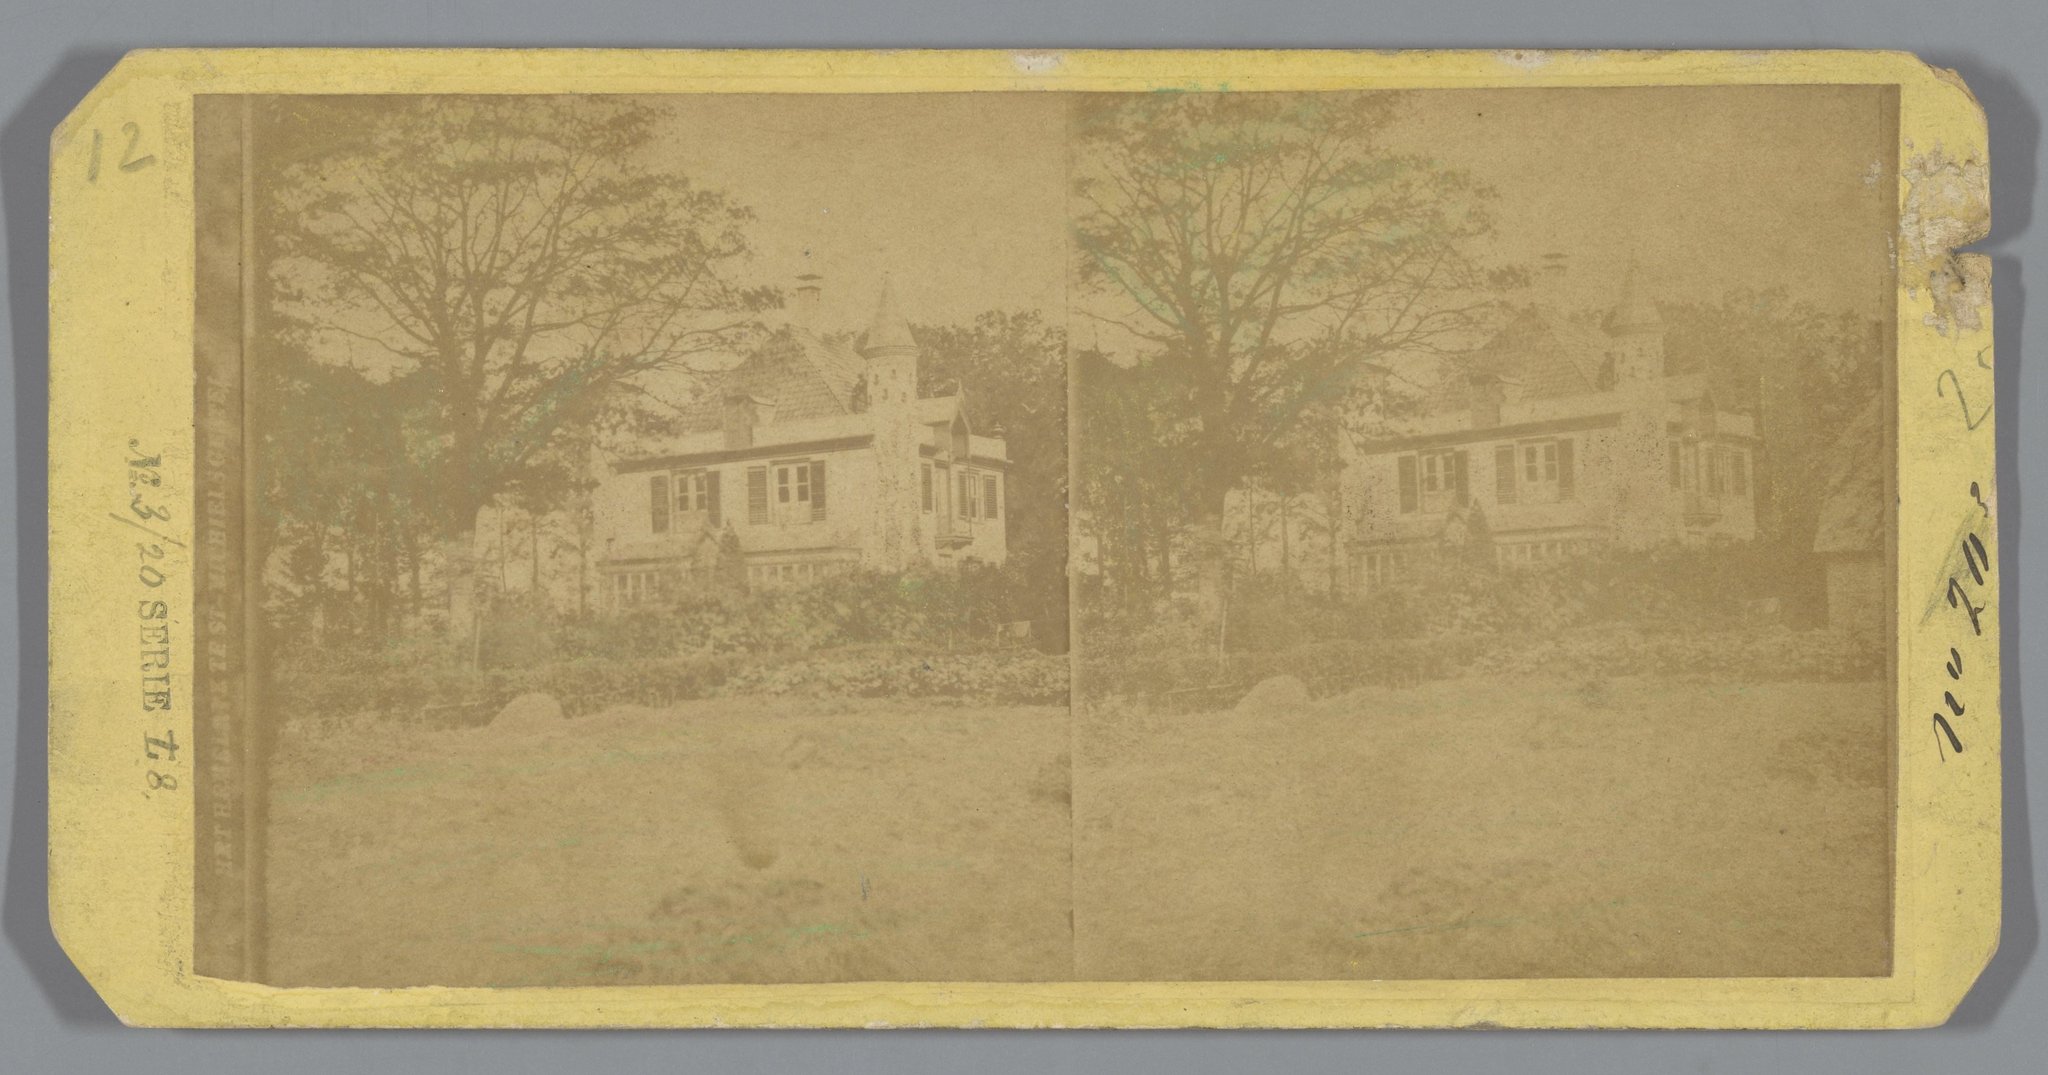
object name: stereograph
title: Het Hemelare te St-Michielsgestel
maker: Anonymous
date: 1868-1890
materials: cardboard, paper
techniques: albumen print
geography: sint-michielsgestel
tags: villa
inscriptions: number: ‘12’, inscription: ‘III/ [...] " 20’, number: ‘No 3/20 Serie I 8’, annotation: ‘Het Hemelrijk/ s' Michiels Gestel’, name: ‘Johan v Leen [?]’